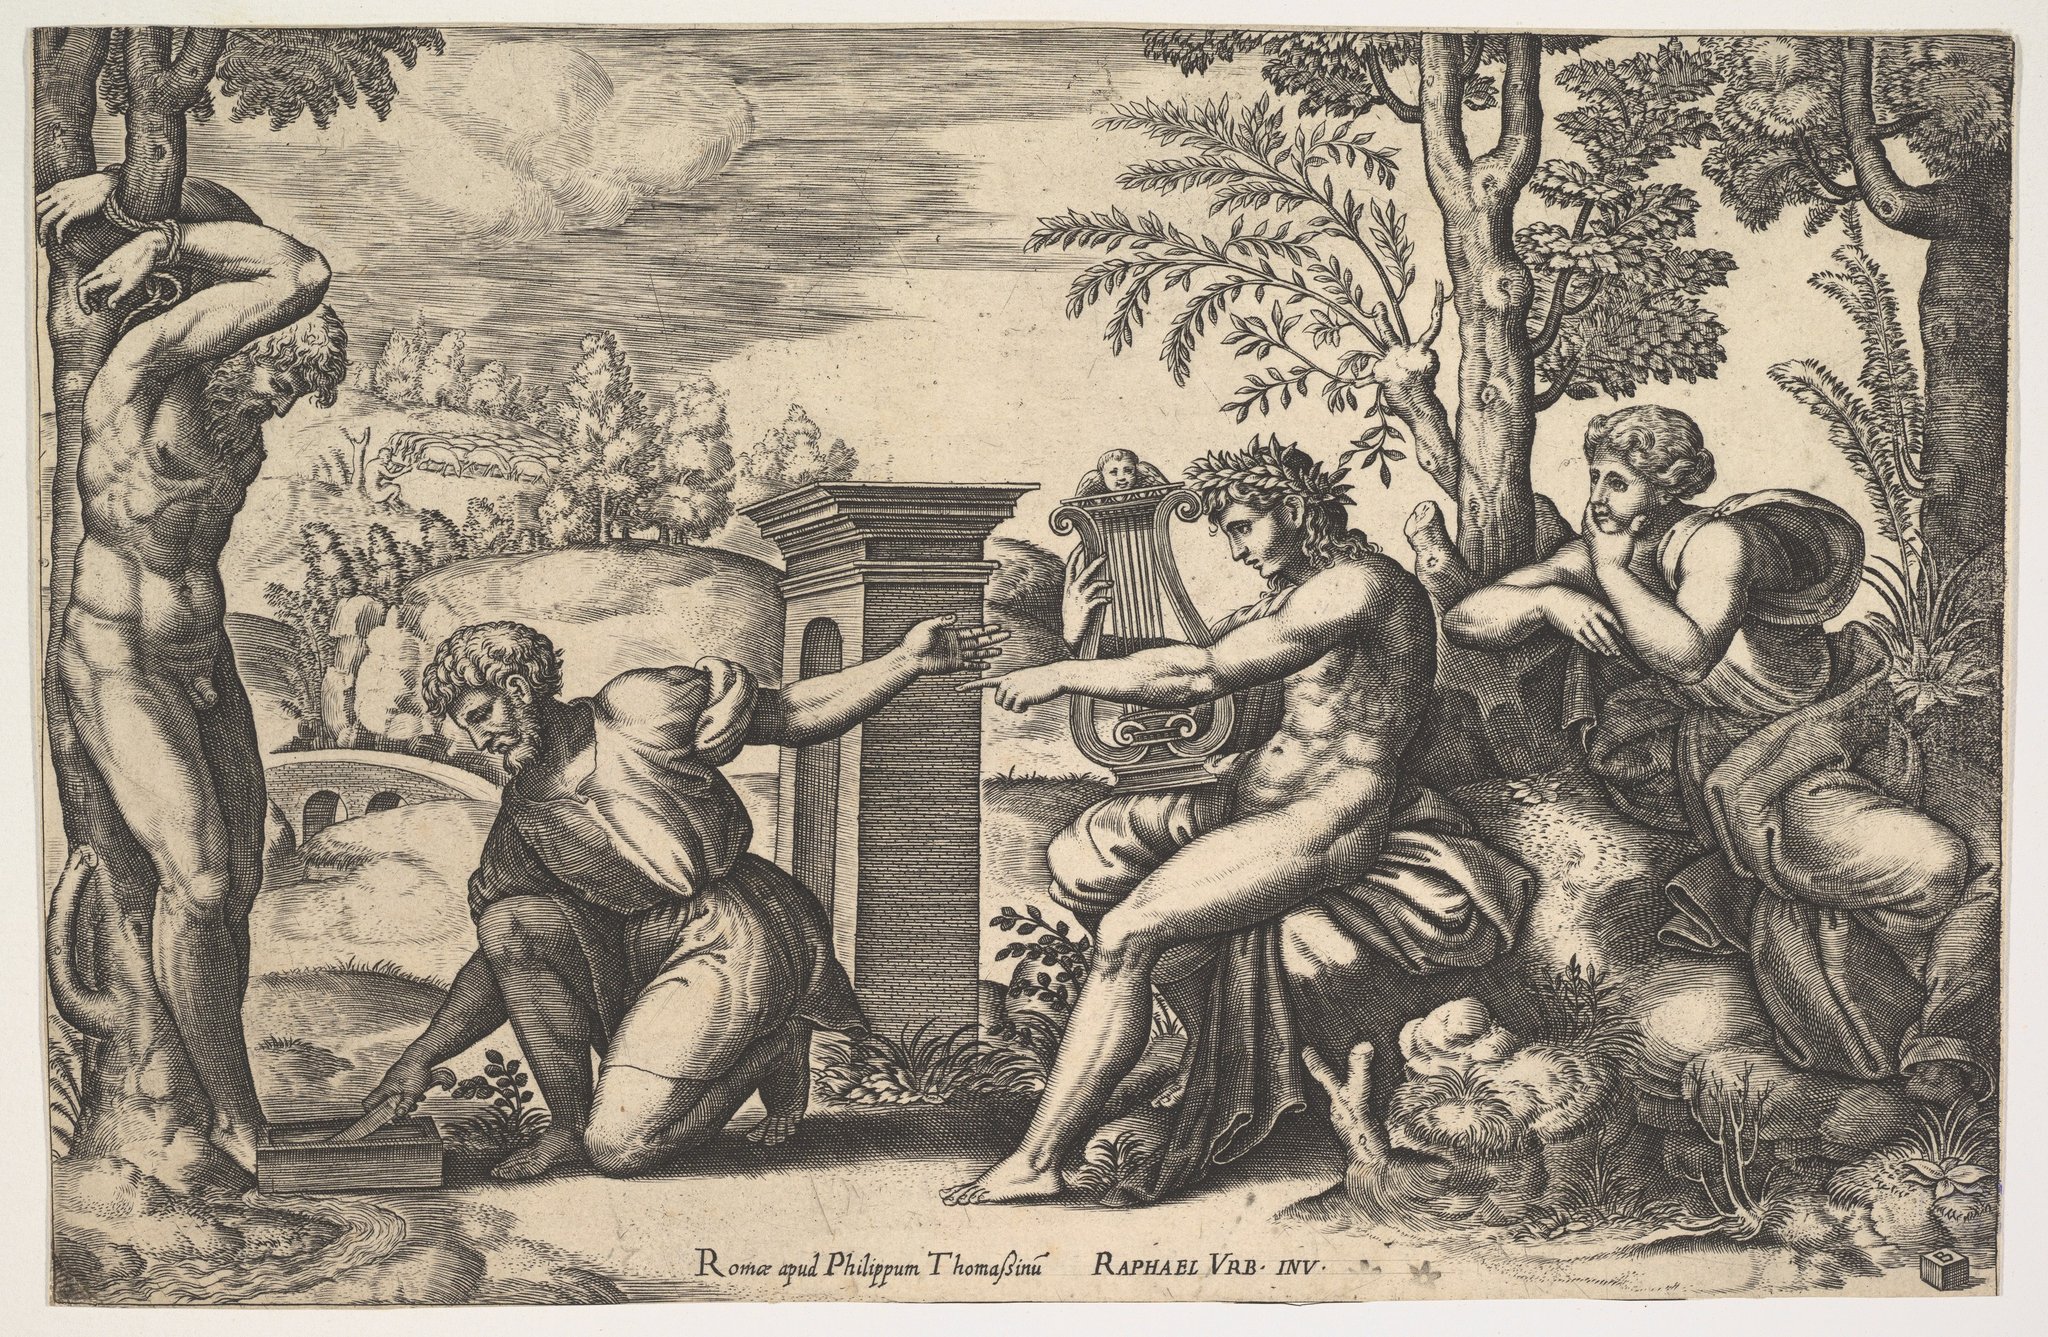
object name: print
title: Apollo seated at the right with a lyre on his knee, pointing to a kneeling man who is about to flay Marsyas who is tied naked to a tree at left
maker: master of the die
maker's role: artist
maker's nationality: italian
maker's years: 1525-1560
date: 1530-1560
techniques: engraving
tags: musical instruments,men,male nudes,apollo